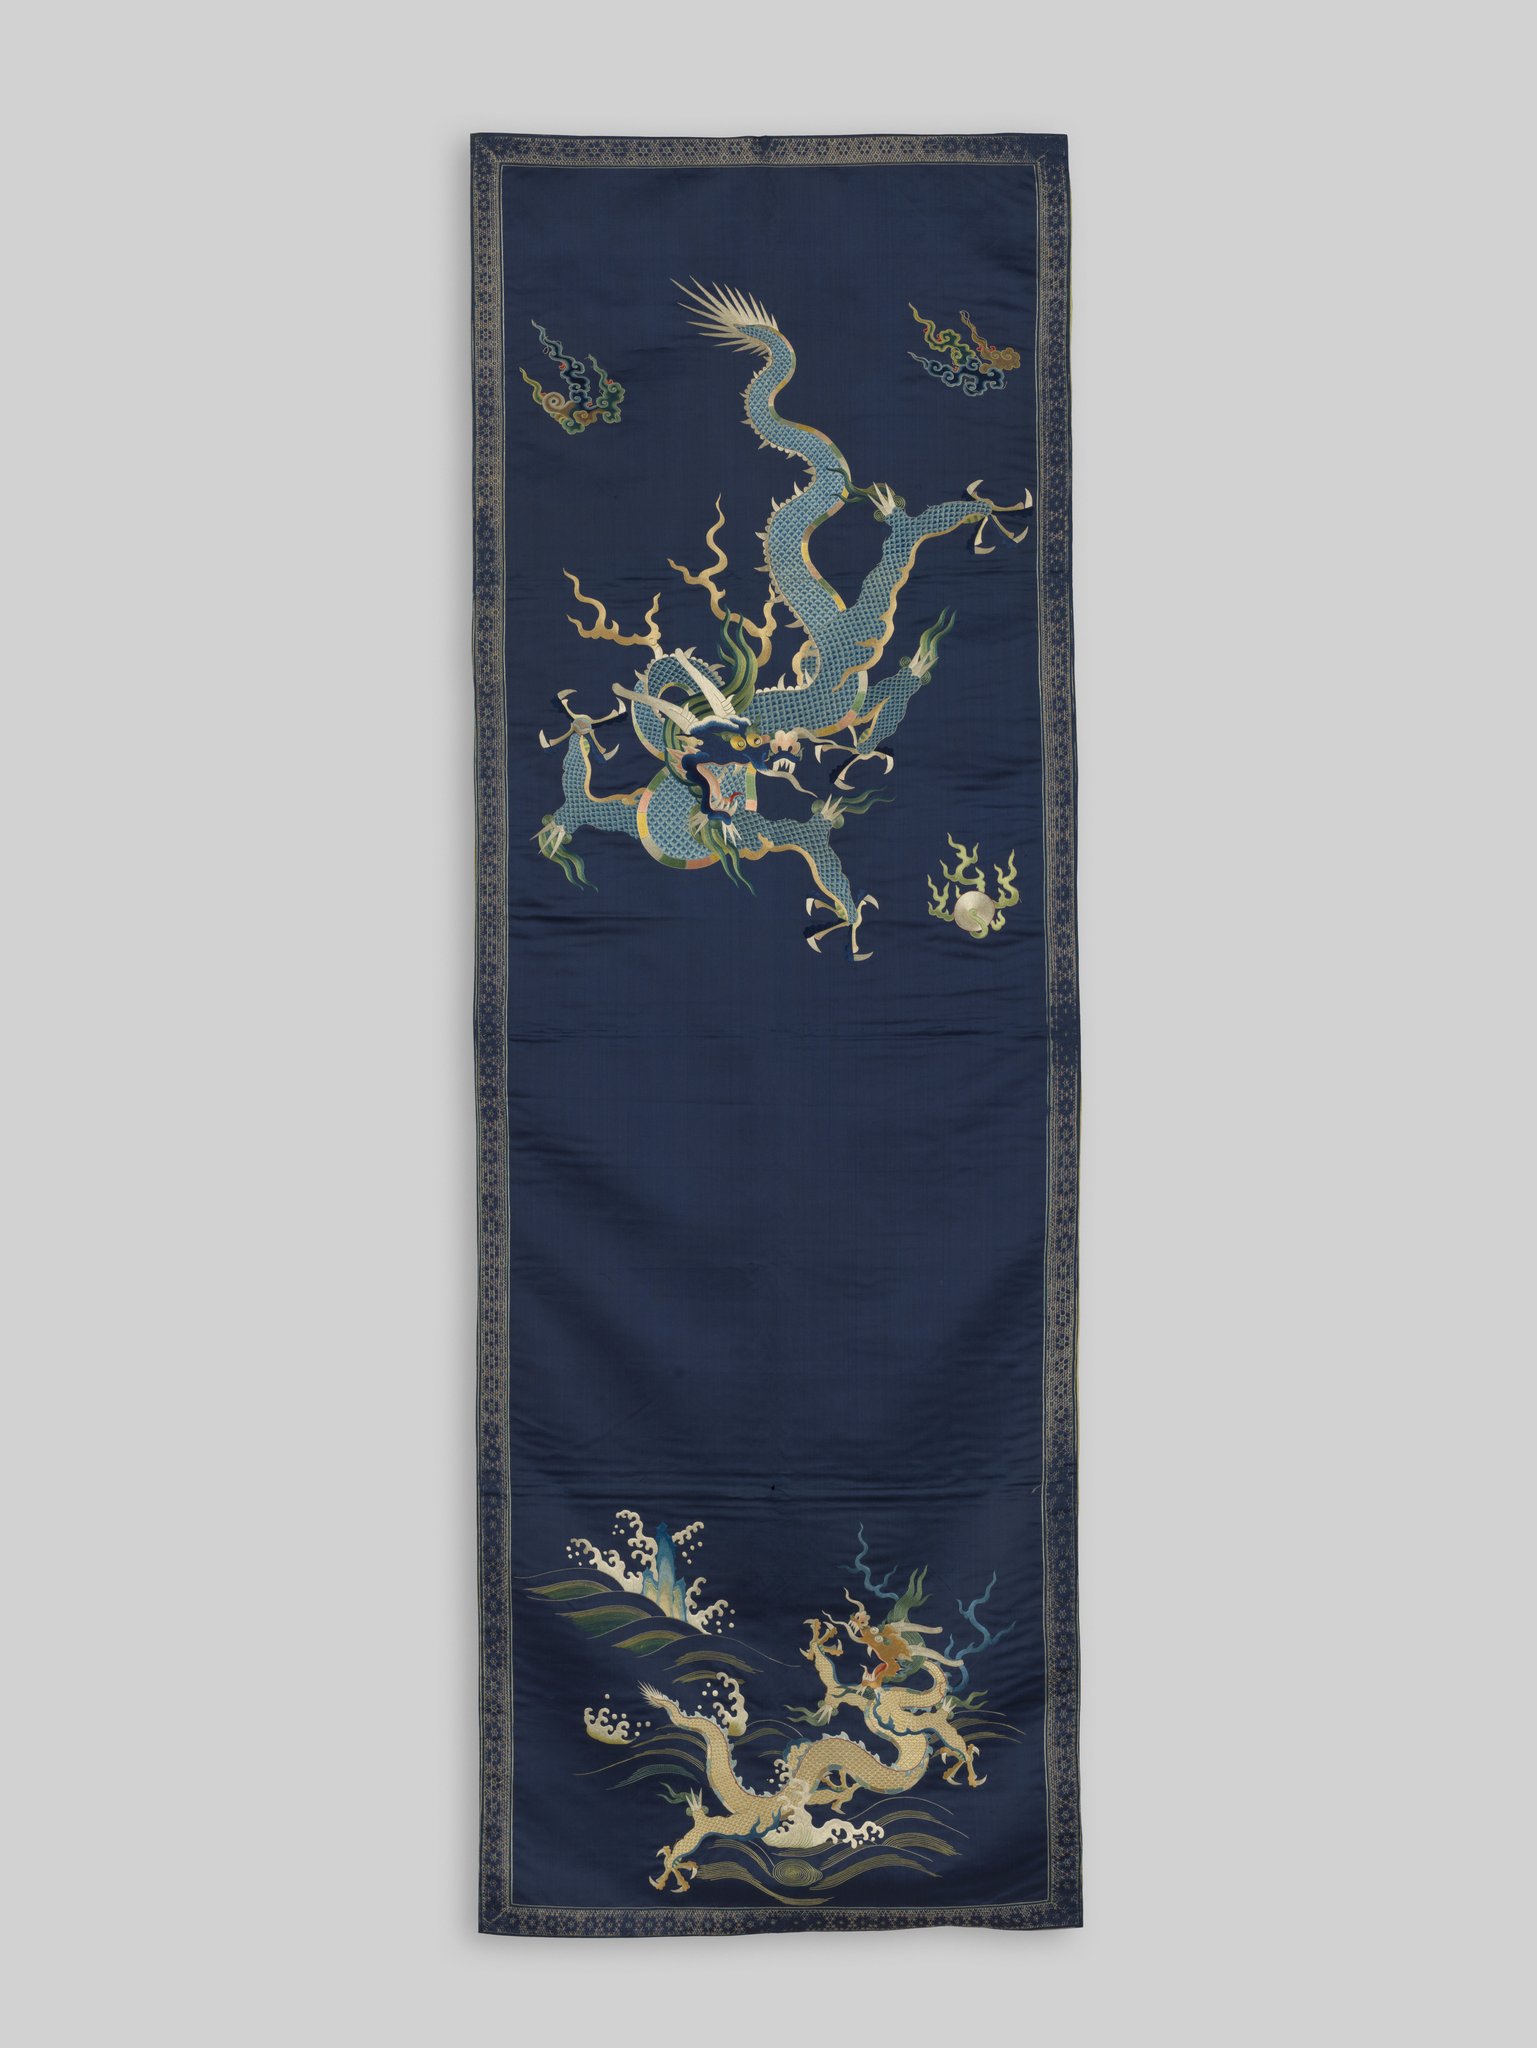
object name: chair strip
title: Chair Strip with Dragons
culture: chinese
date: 1701-1800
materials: silk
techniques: embroidery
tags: dragons